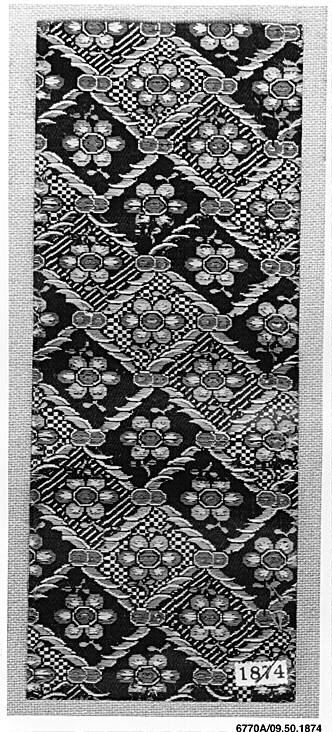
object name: piece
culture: japanese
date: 1615-1868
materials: silk